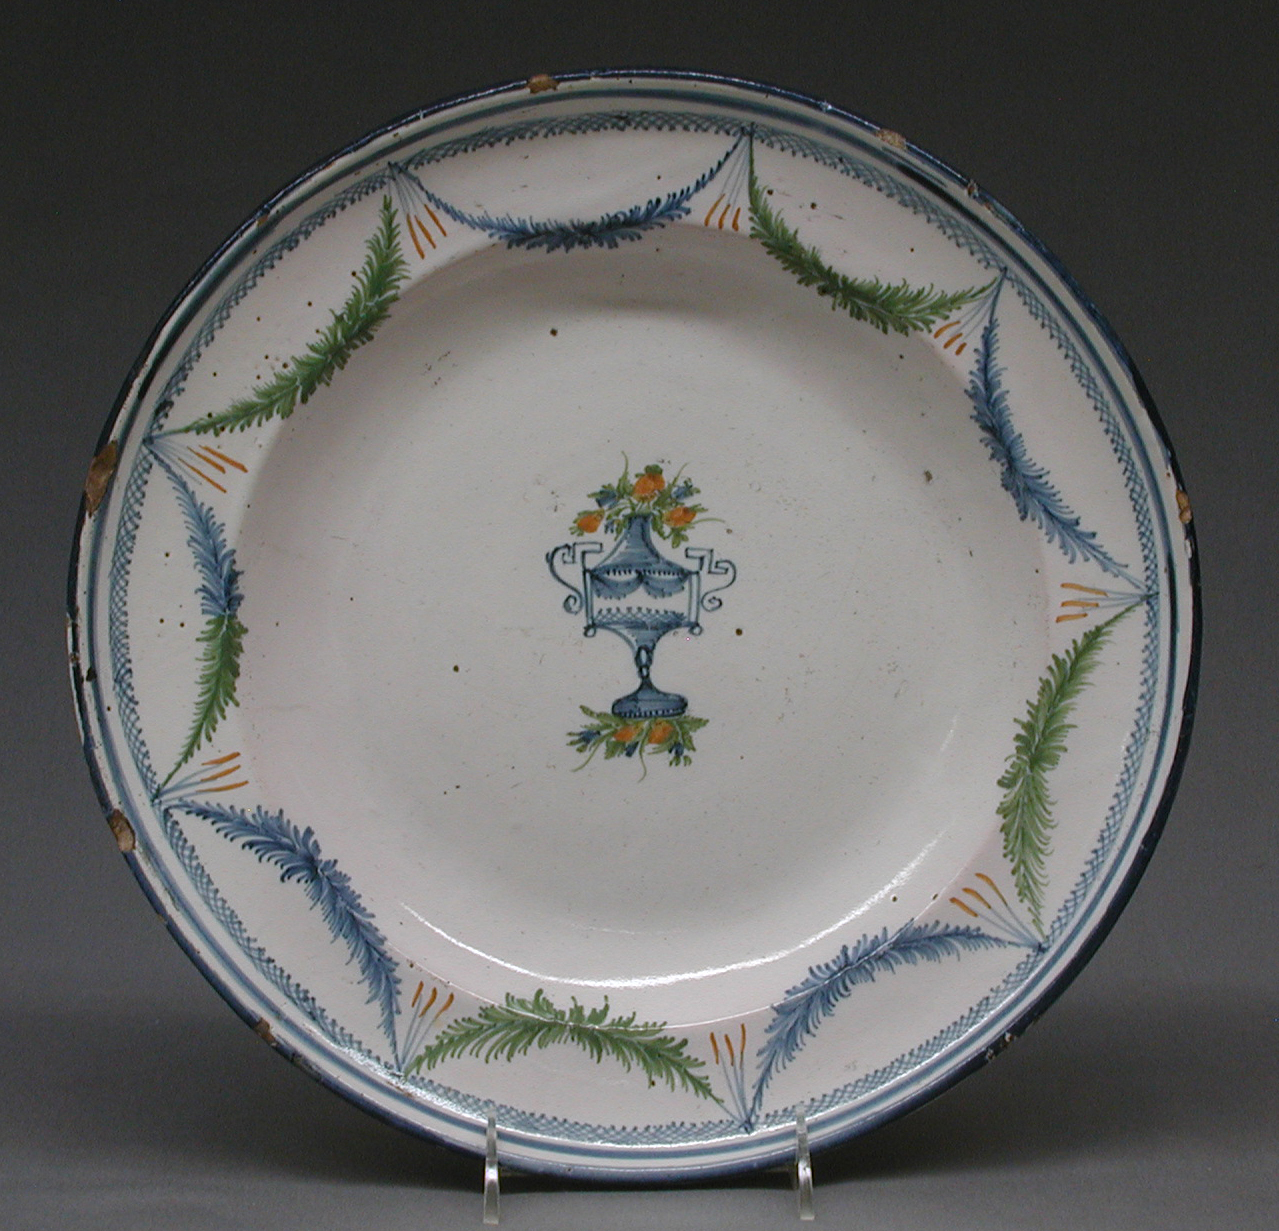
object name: plaque or plate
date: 1701-1800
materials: earthenware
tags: flowers